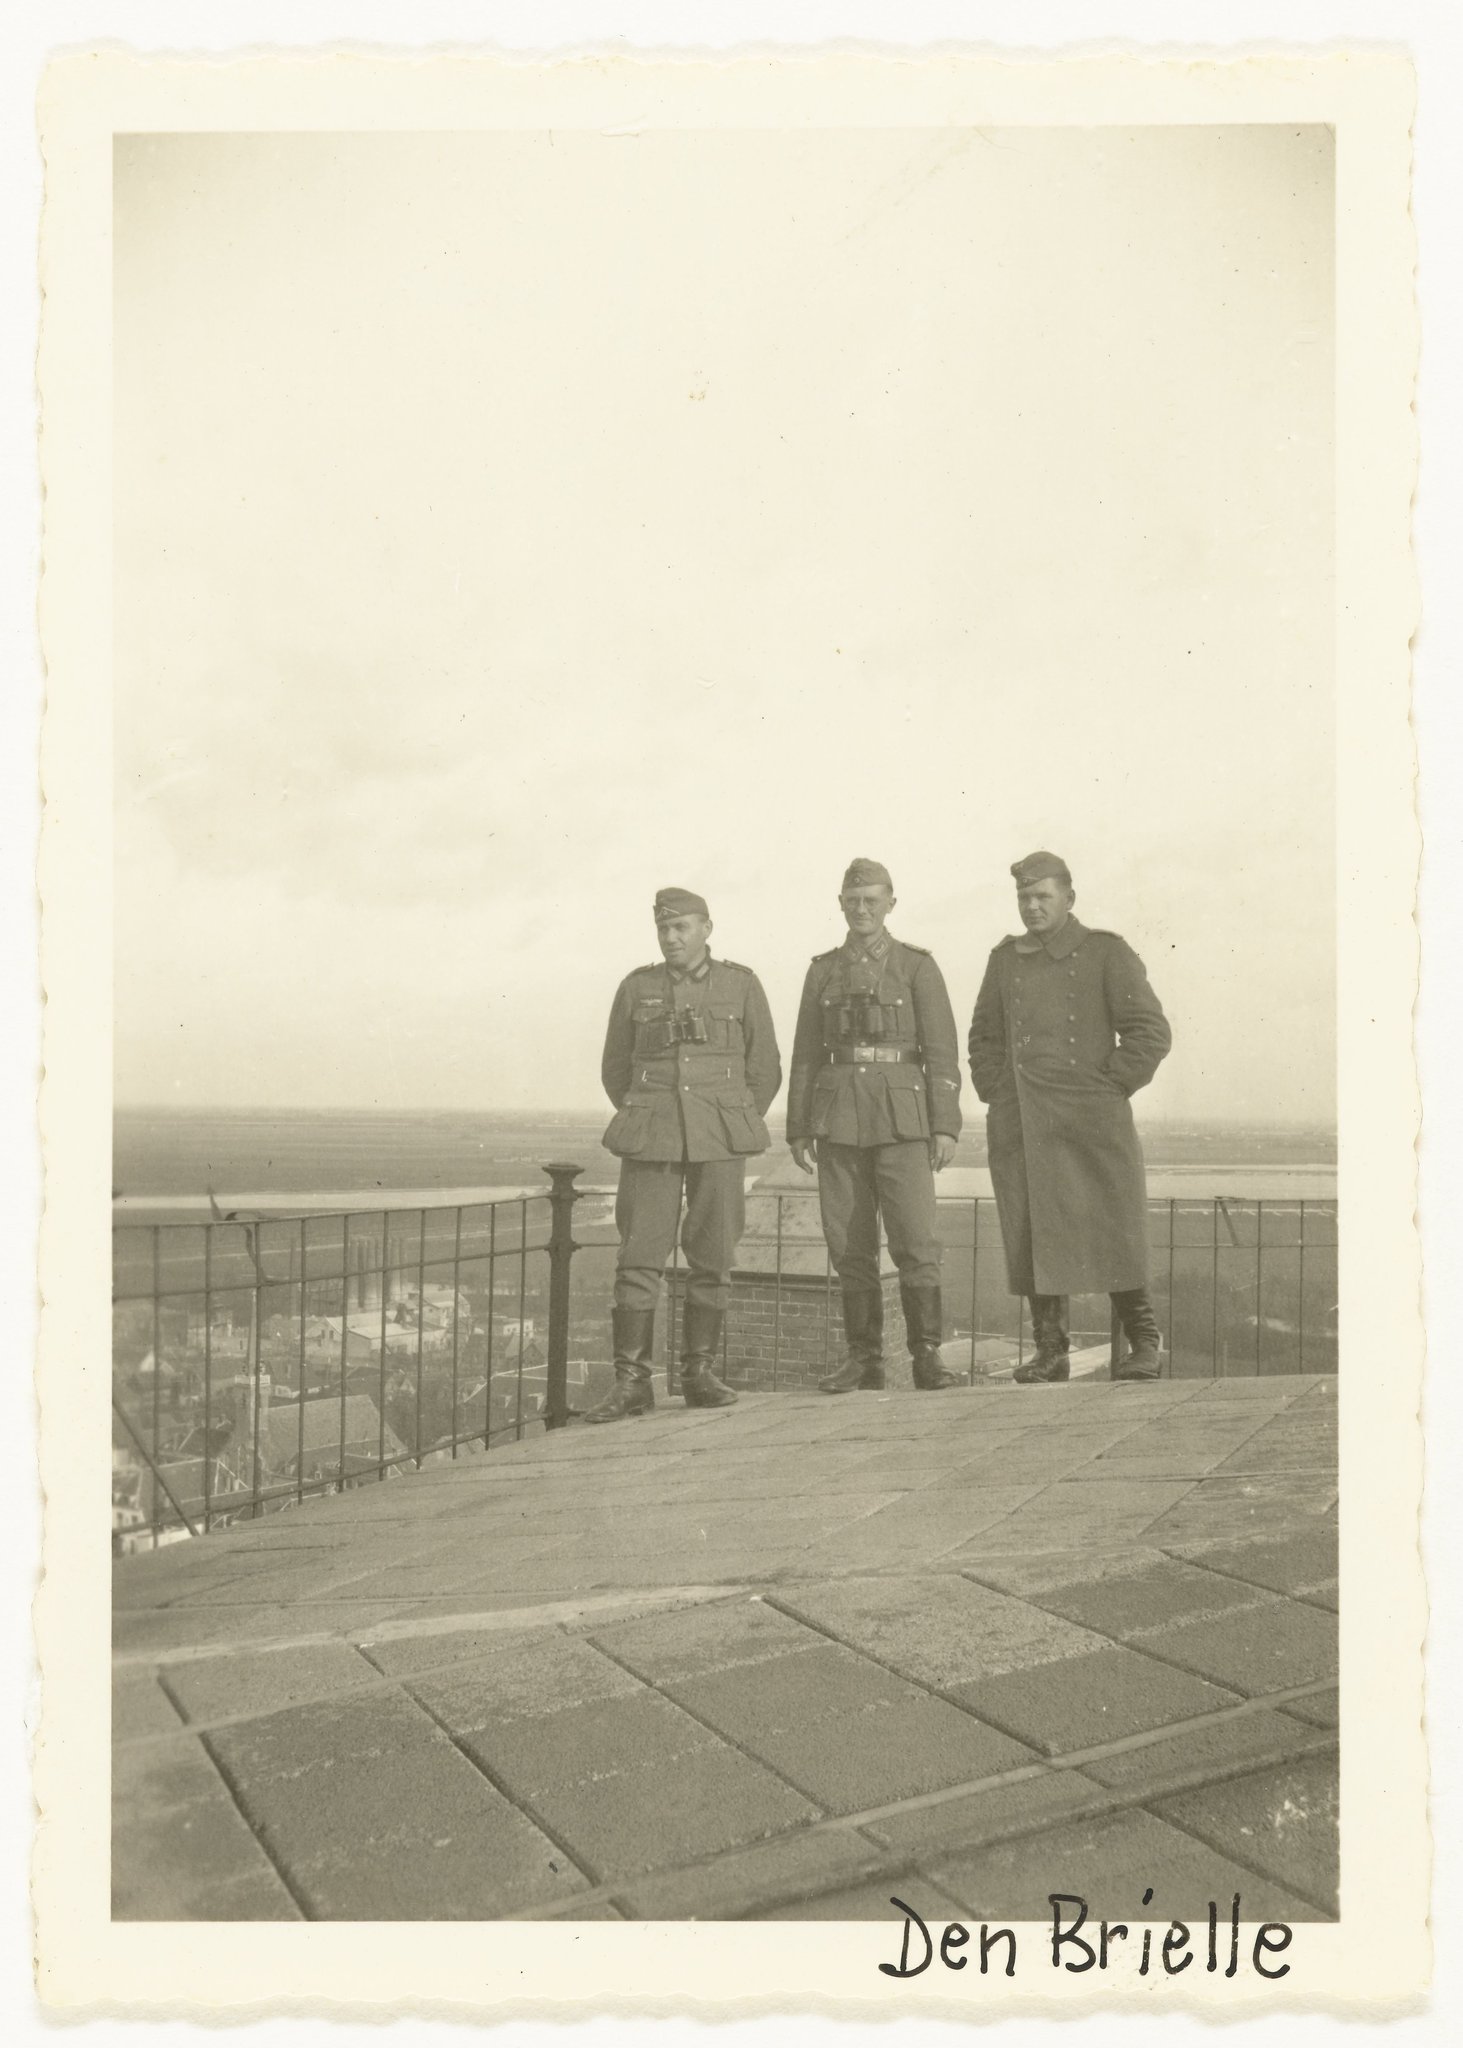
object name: photograph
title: Wehrmacht soldaten op het dak van een kerk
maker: Anonymous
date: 1940-1941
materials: photographic support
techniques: gelatin silver print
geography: brielle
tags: occupation ~ war, brielle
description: Drie Wehrmachtsoldaten staan op het dak van een kerk in Brielle. Middelste is soldaat met bril.